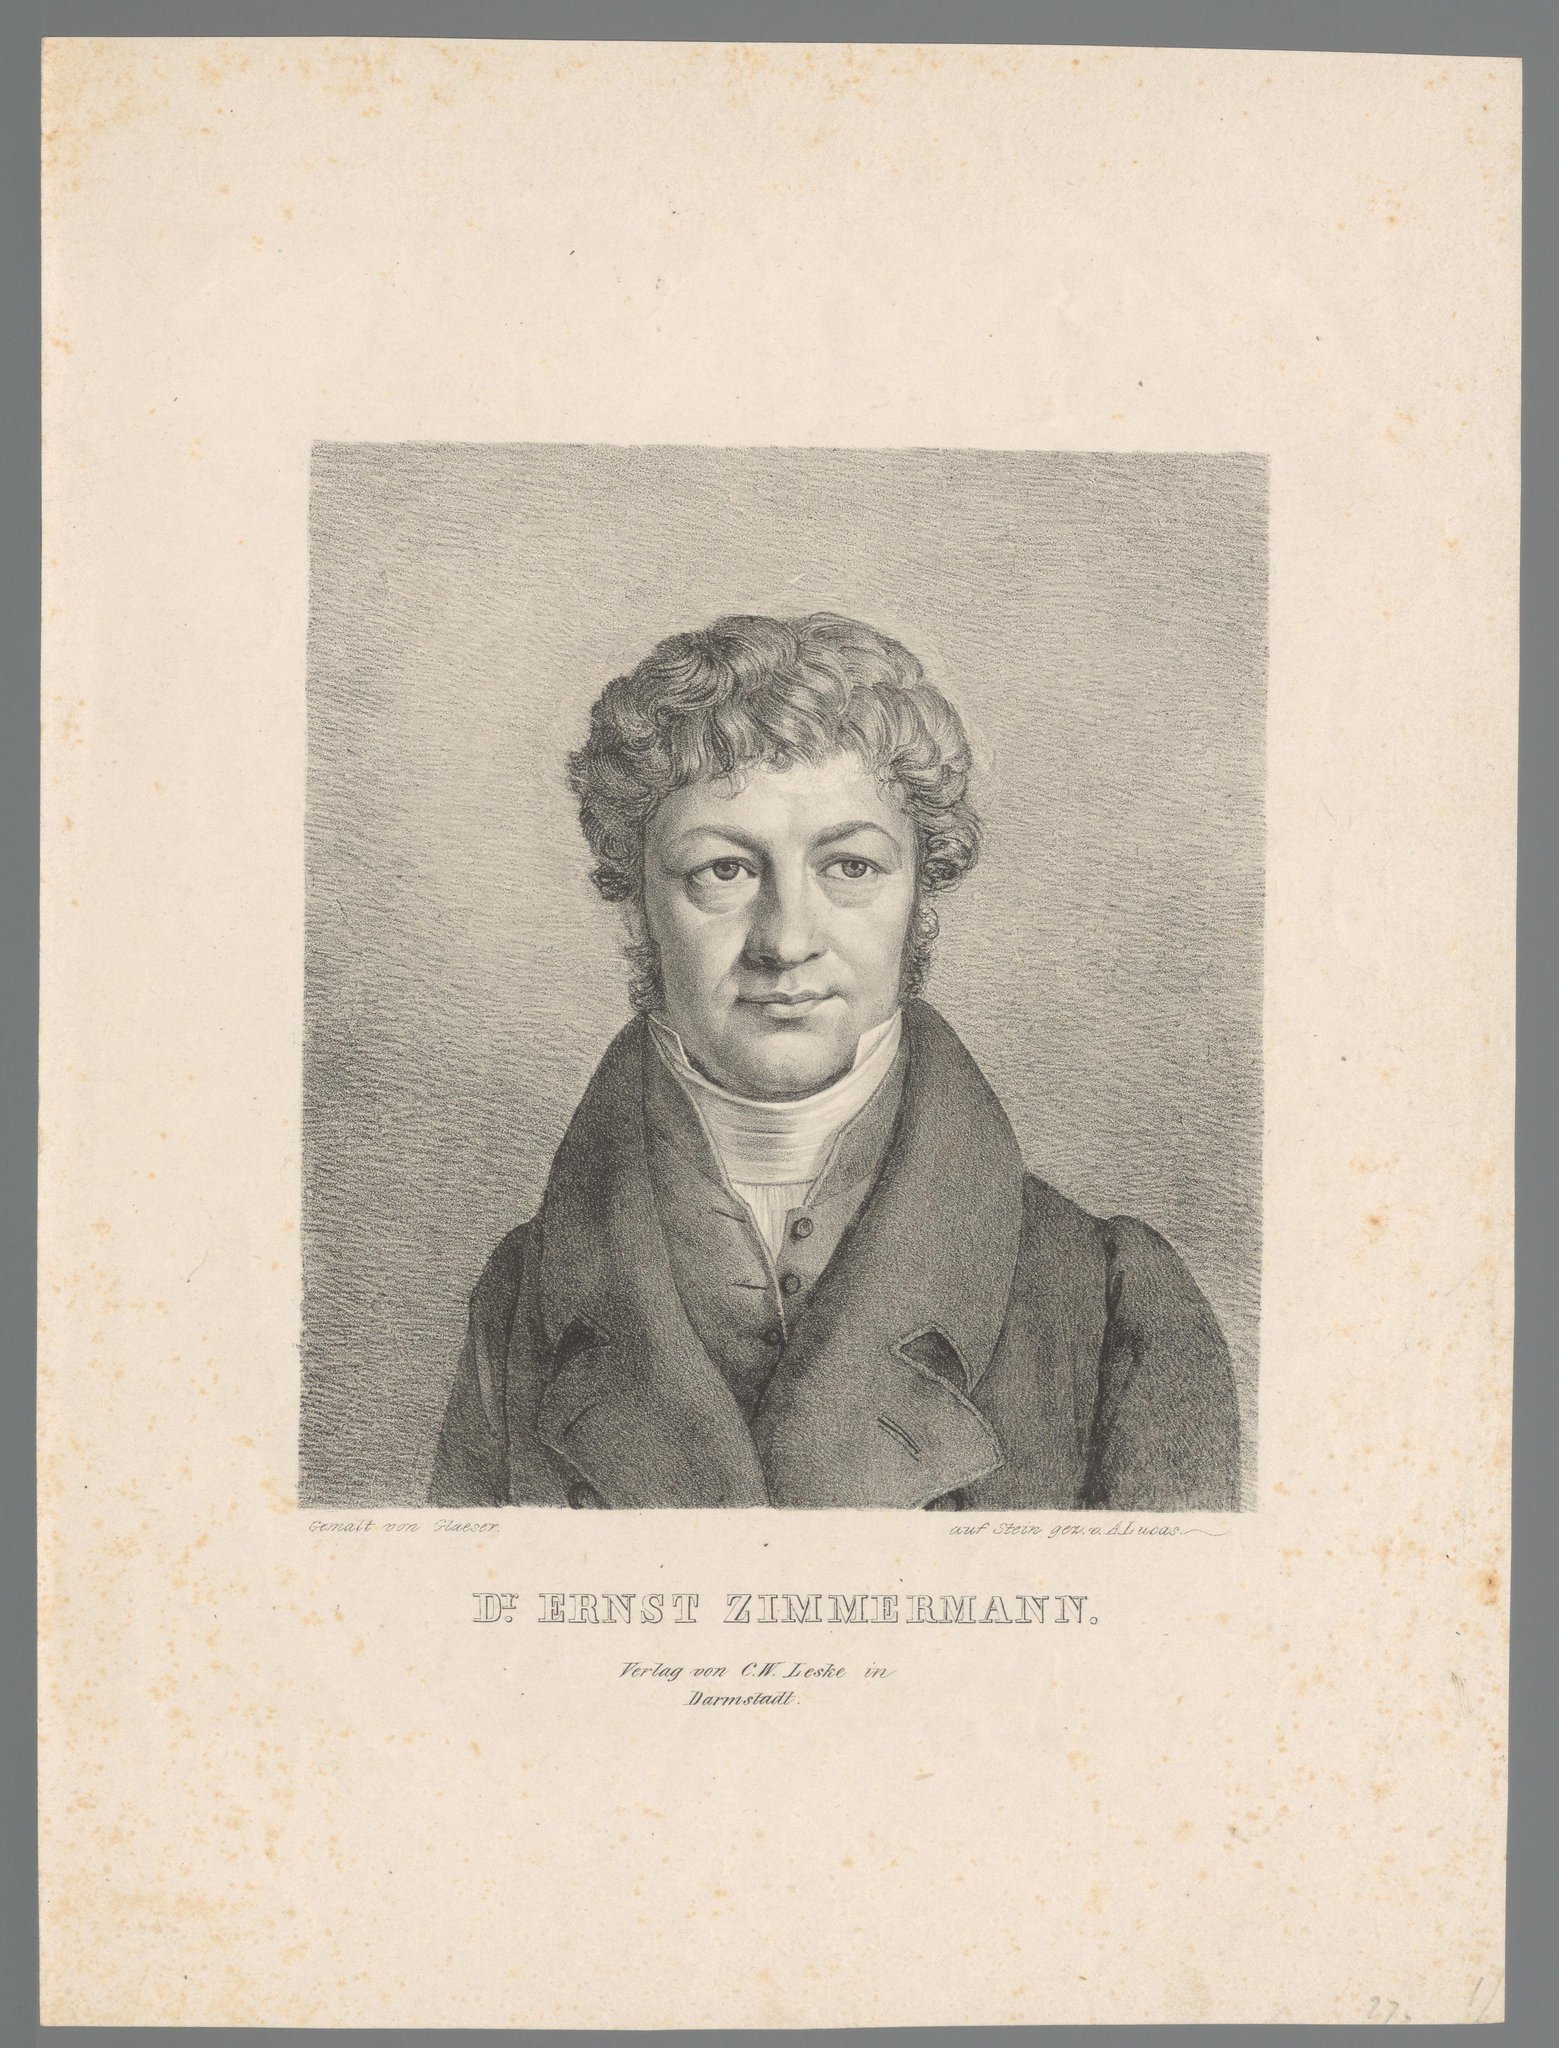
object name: print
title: Dr. Ernst Zimmermann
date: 1813-1837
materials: paper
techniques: lithograph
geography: darmstadt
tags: theologian, historical persons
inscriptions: collector's mark: Lugt 2228